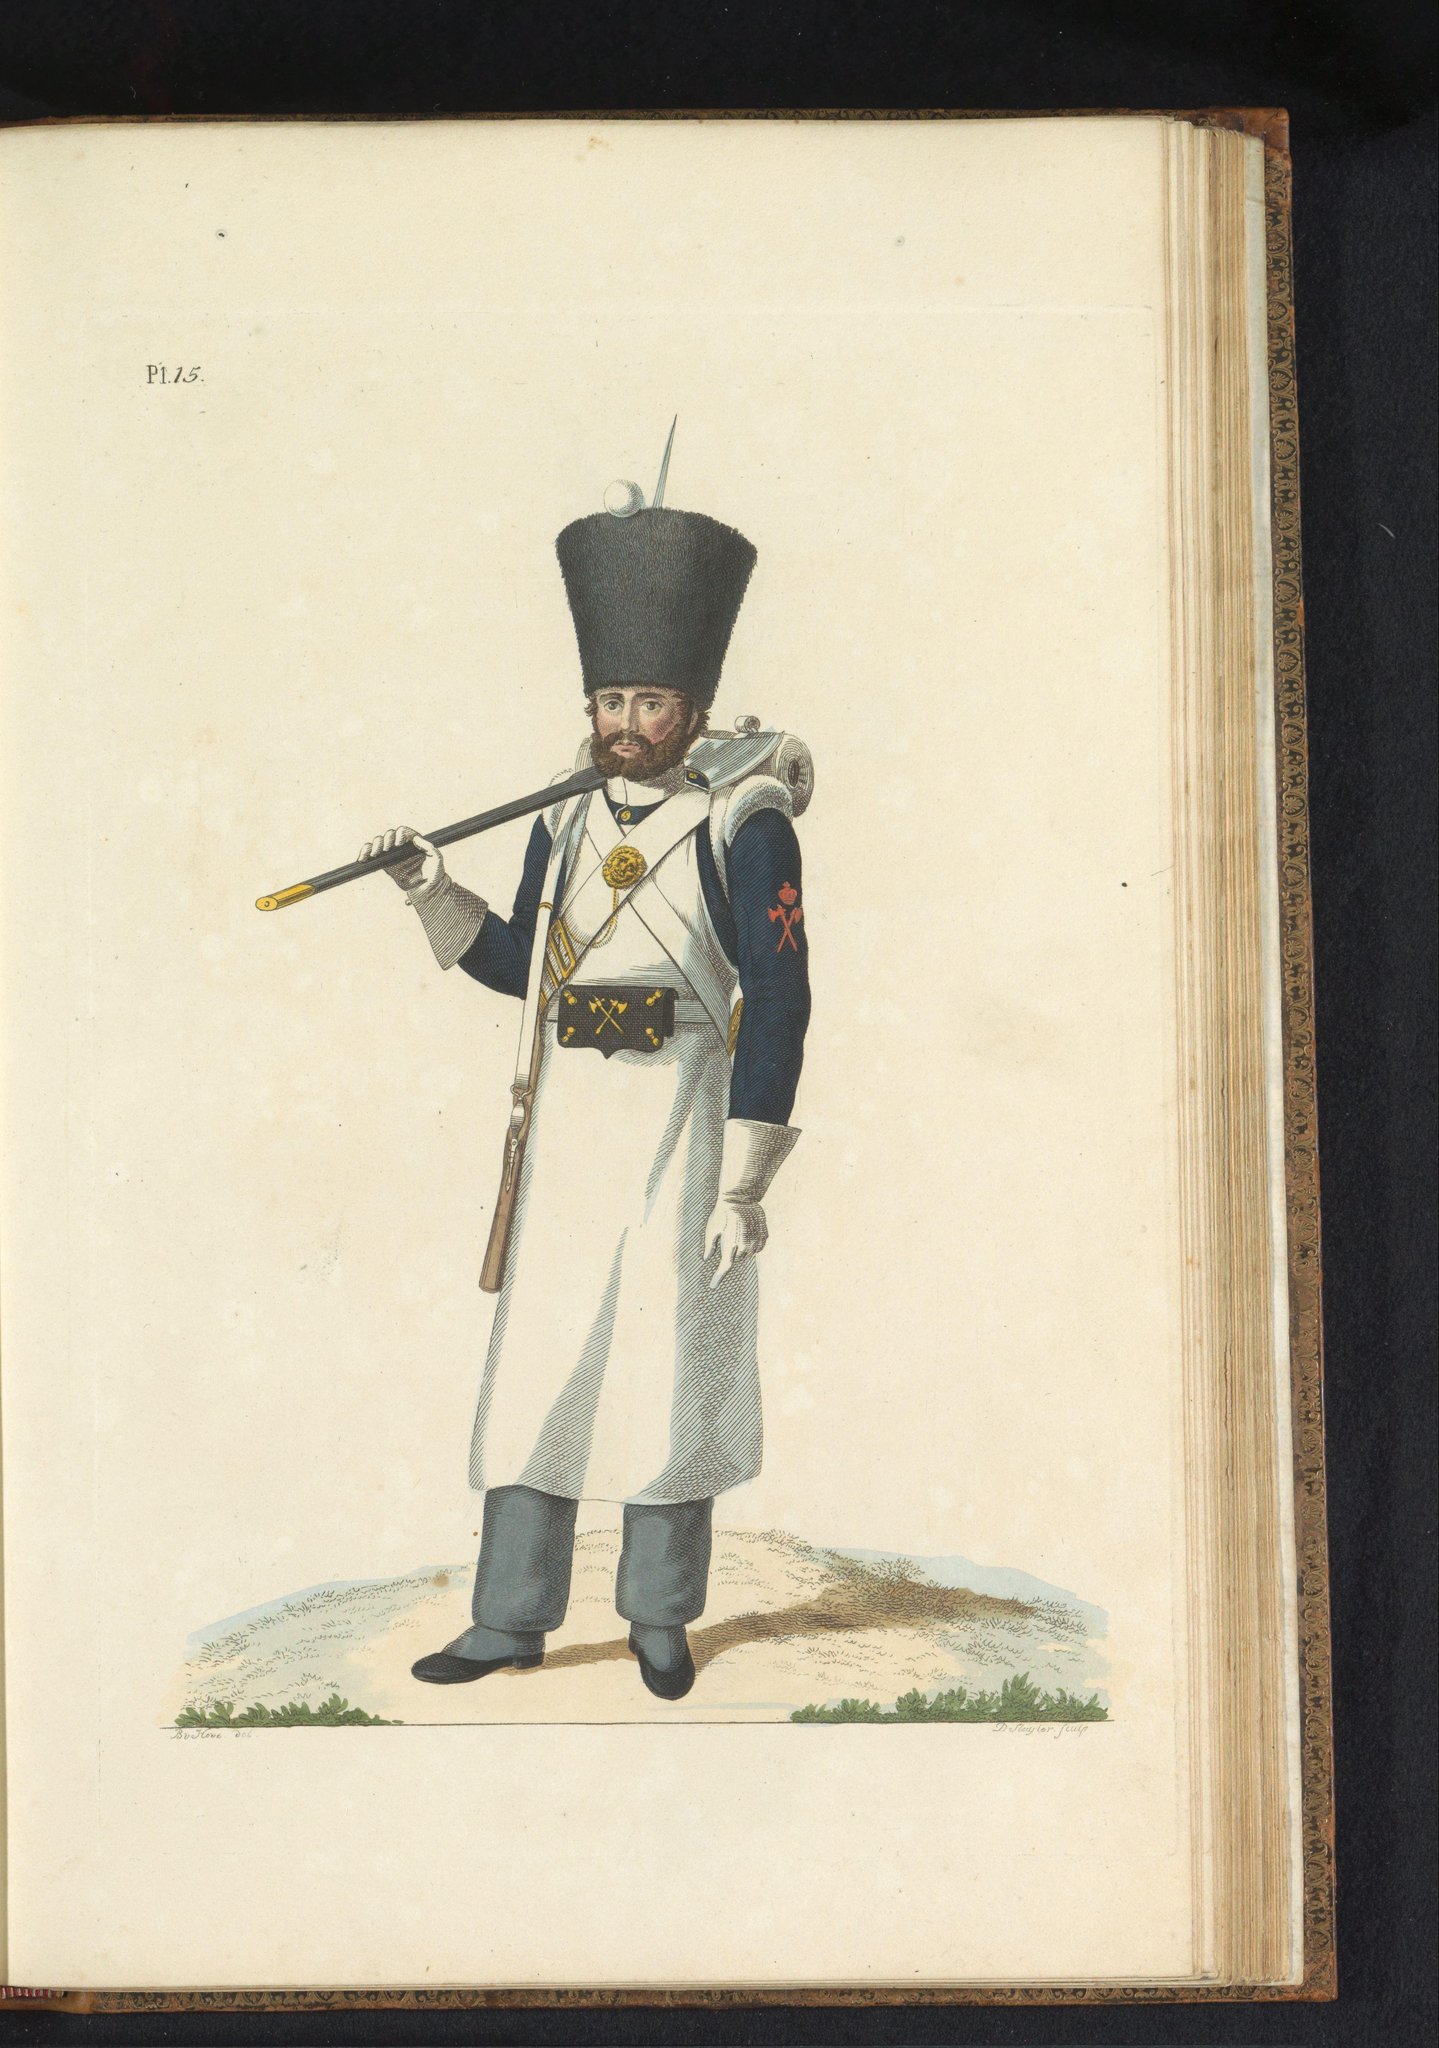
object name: print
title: Sappeur, der Nationale Infanterie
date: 1823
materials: paper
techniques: engraving, etching, hand coloring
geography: the hague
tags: (military) uniforms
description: Een Nederlandse sappeur van de Nationale Infanterie, met de bijl op de schouder. Plaat 15. Uniformvoorstelling in 'Beschrijving hoedanig de Koninklijke Nederlandsche troepen' van J.F. Teupken, 1823.